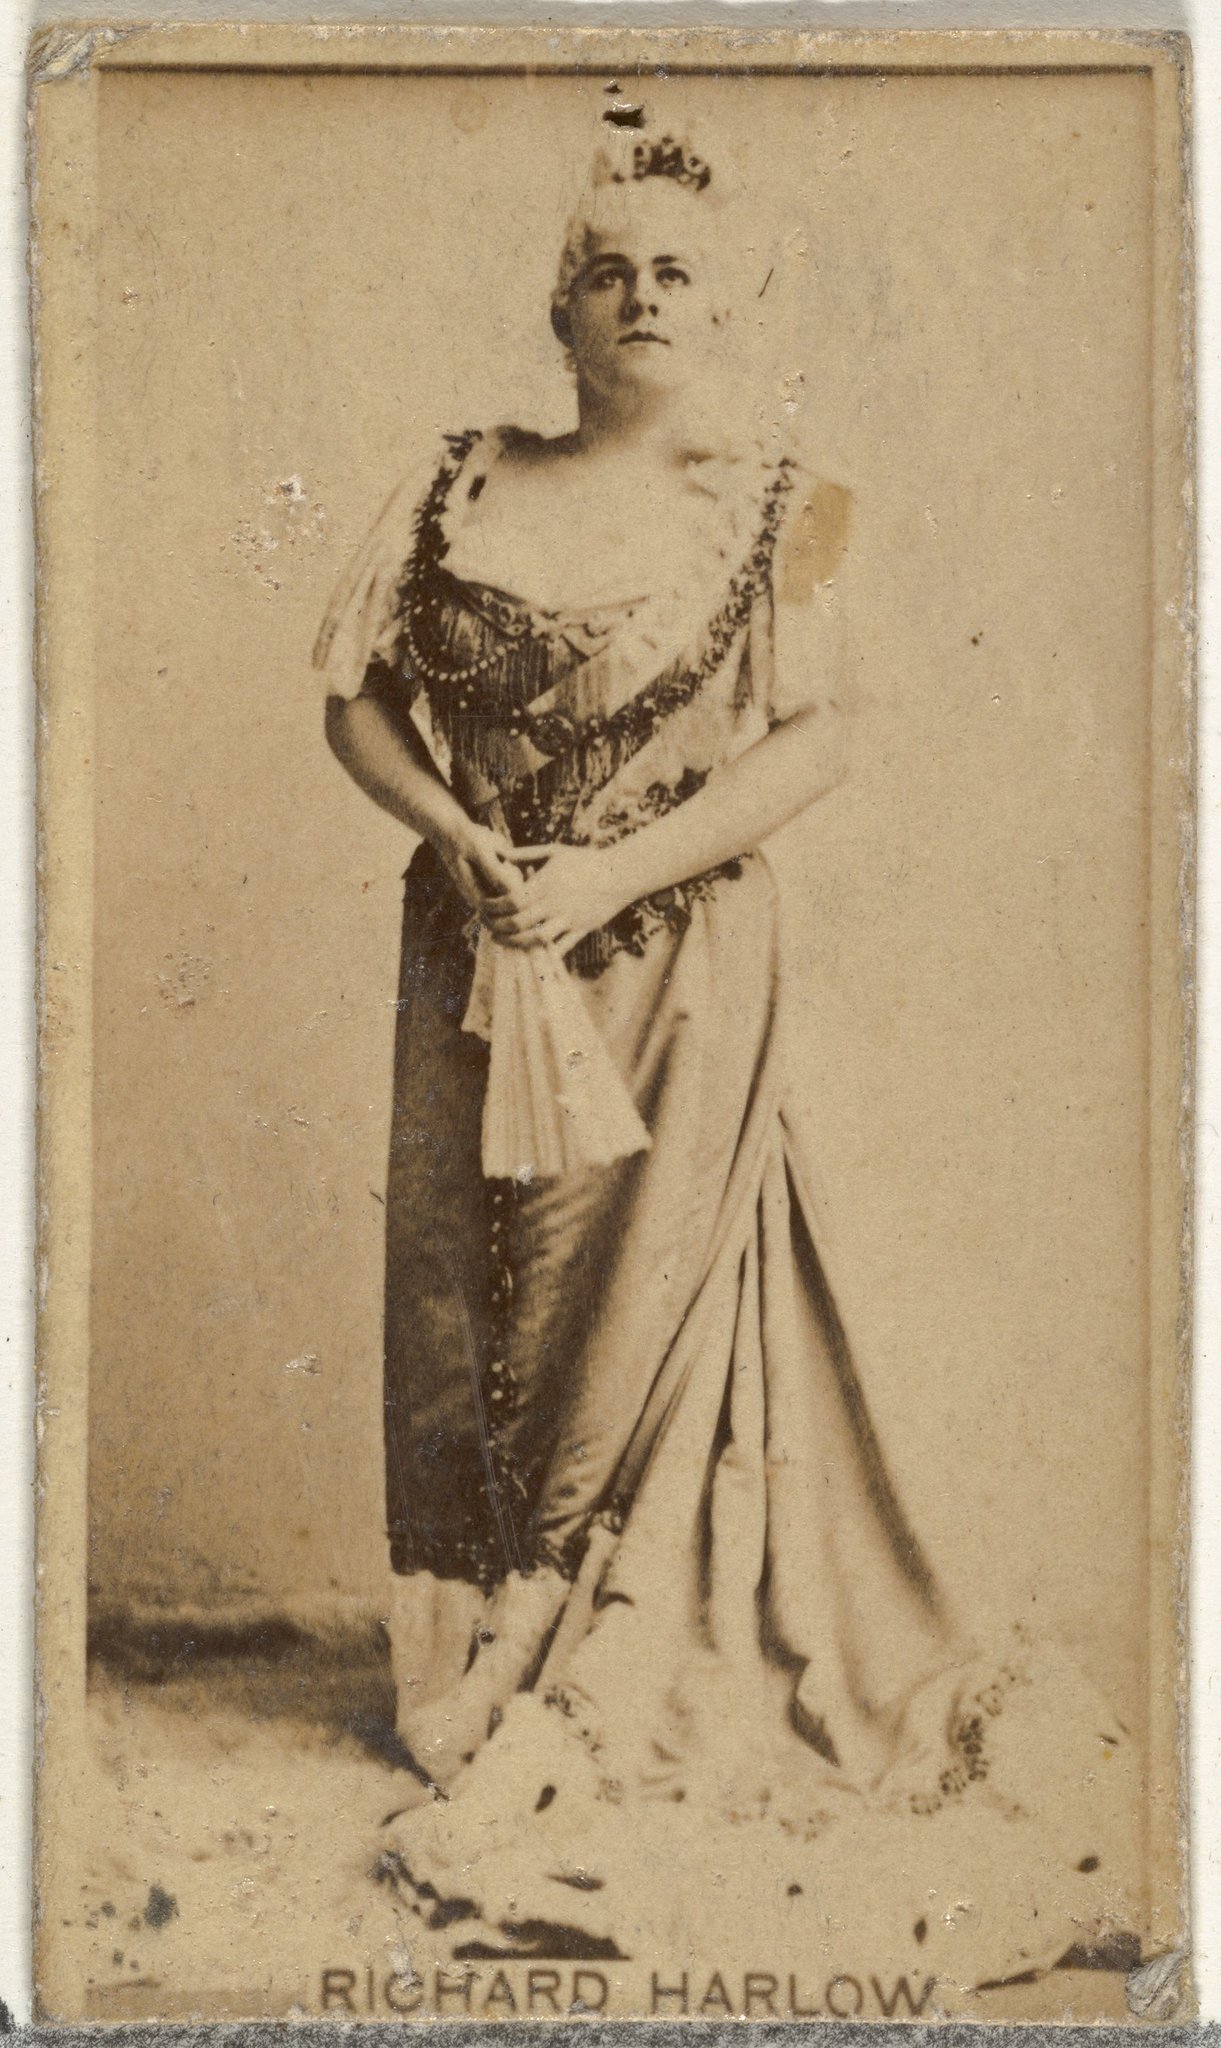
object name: photograph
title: Richard Harlow, from the Actors and Actresses series (N145-8) issued by Duke Sons & Co. to promote Duke Cigarettes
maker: w. duke, sons & co.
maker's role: publisher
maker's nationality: american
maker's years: 1870-1920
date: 1891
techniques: albumen silver print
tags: portraits,women,actresses